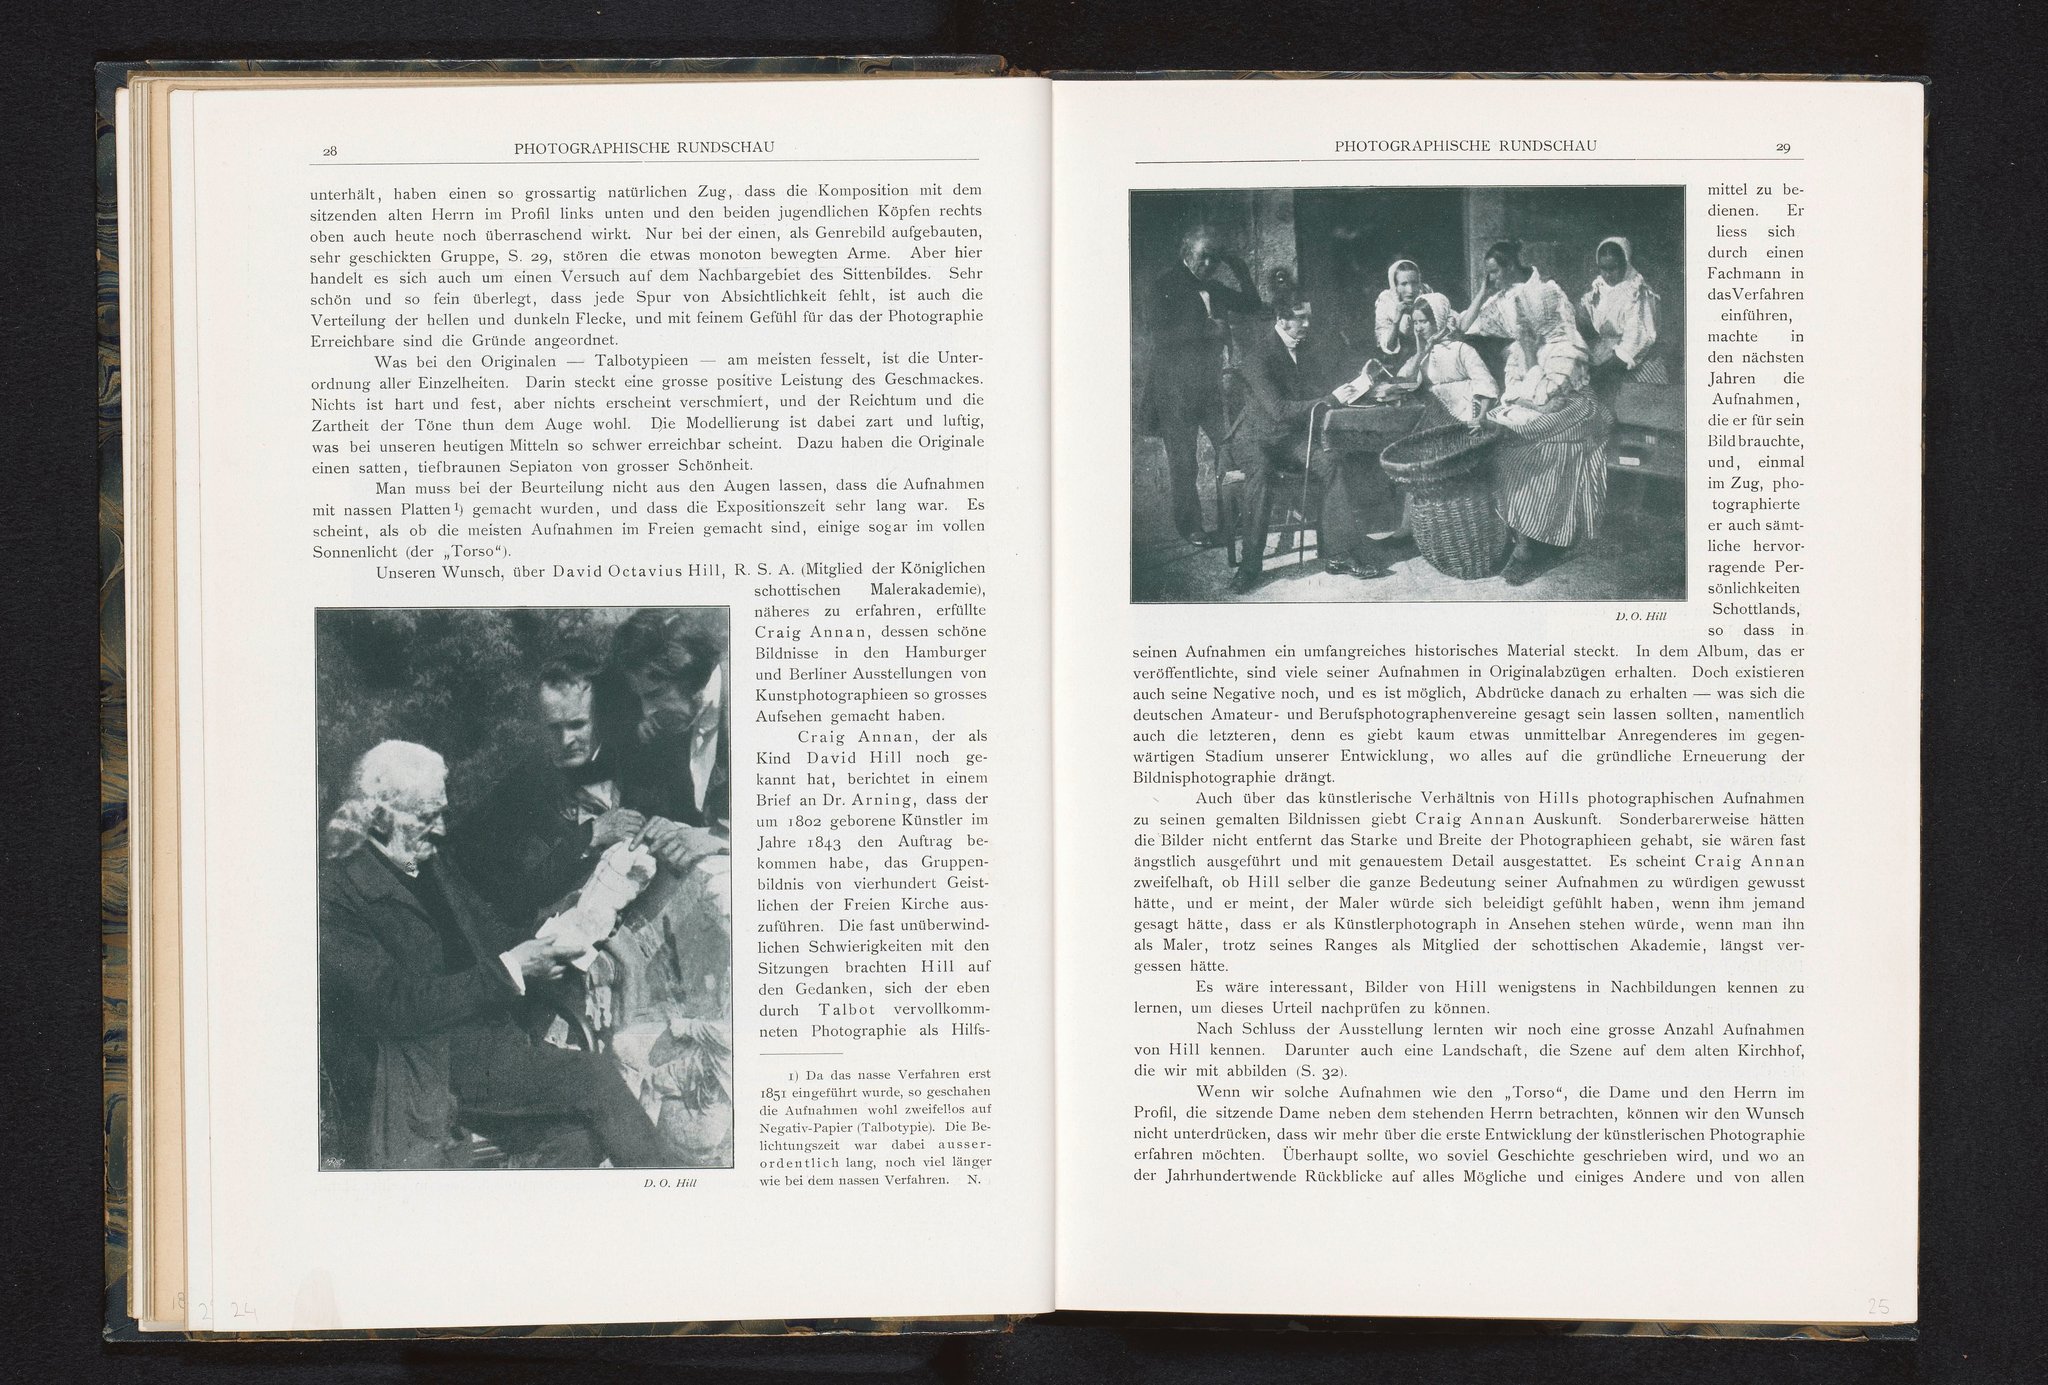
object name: photomechanical print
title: Portret van een groep onbekende vrouwen en twee onbekende mannen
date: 1895-1900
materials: paper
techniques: autotype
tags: anonymous historical persons portrayed in a group, in a group-portrait